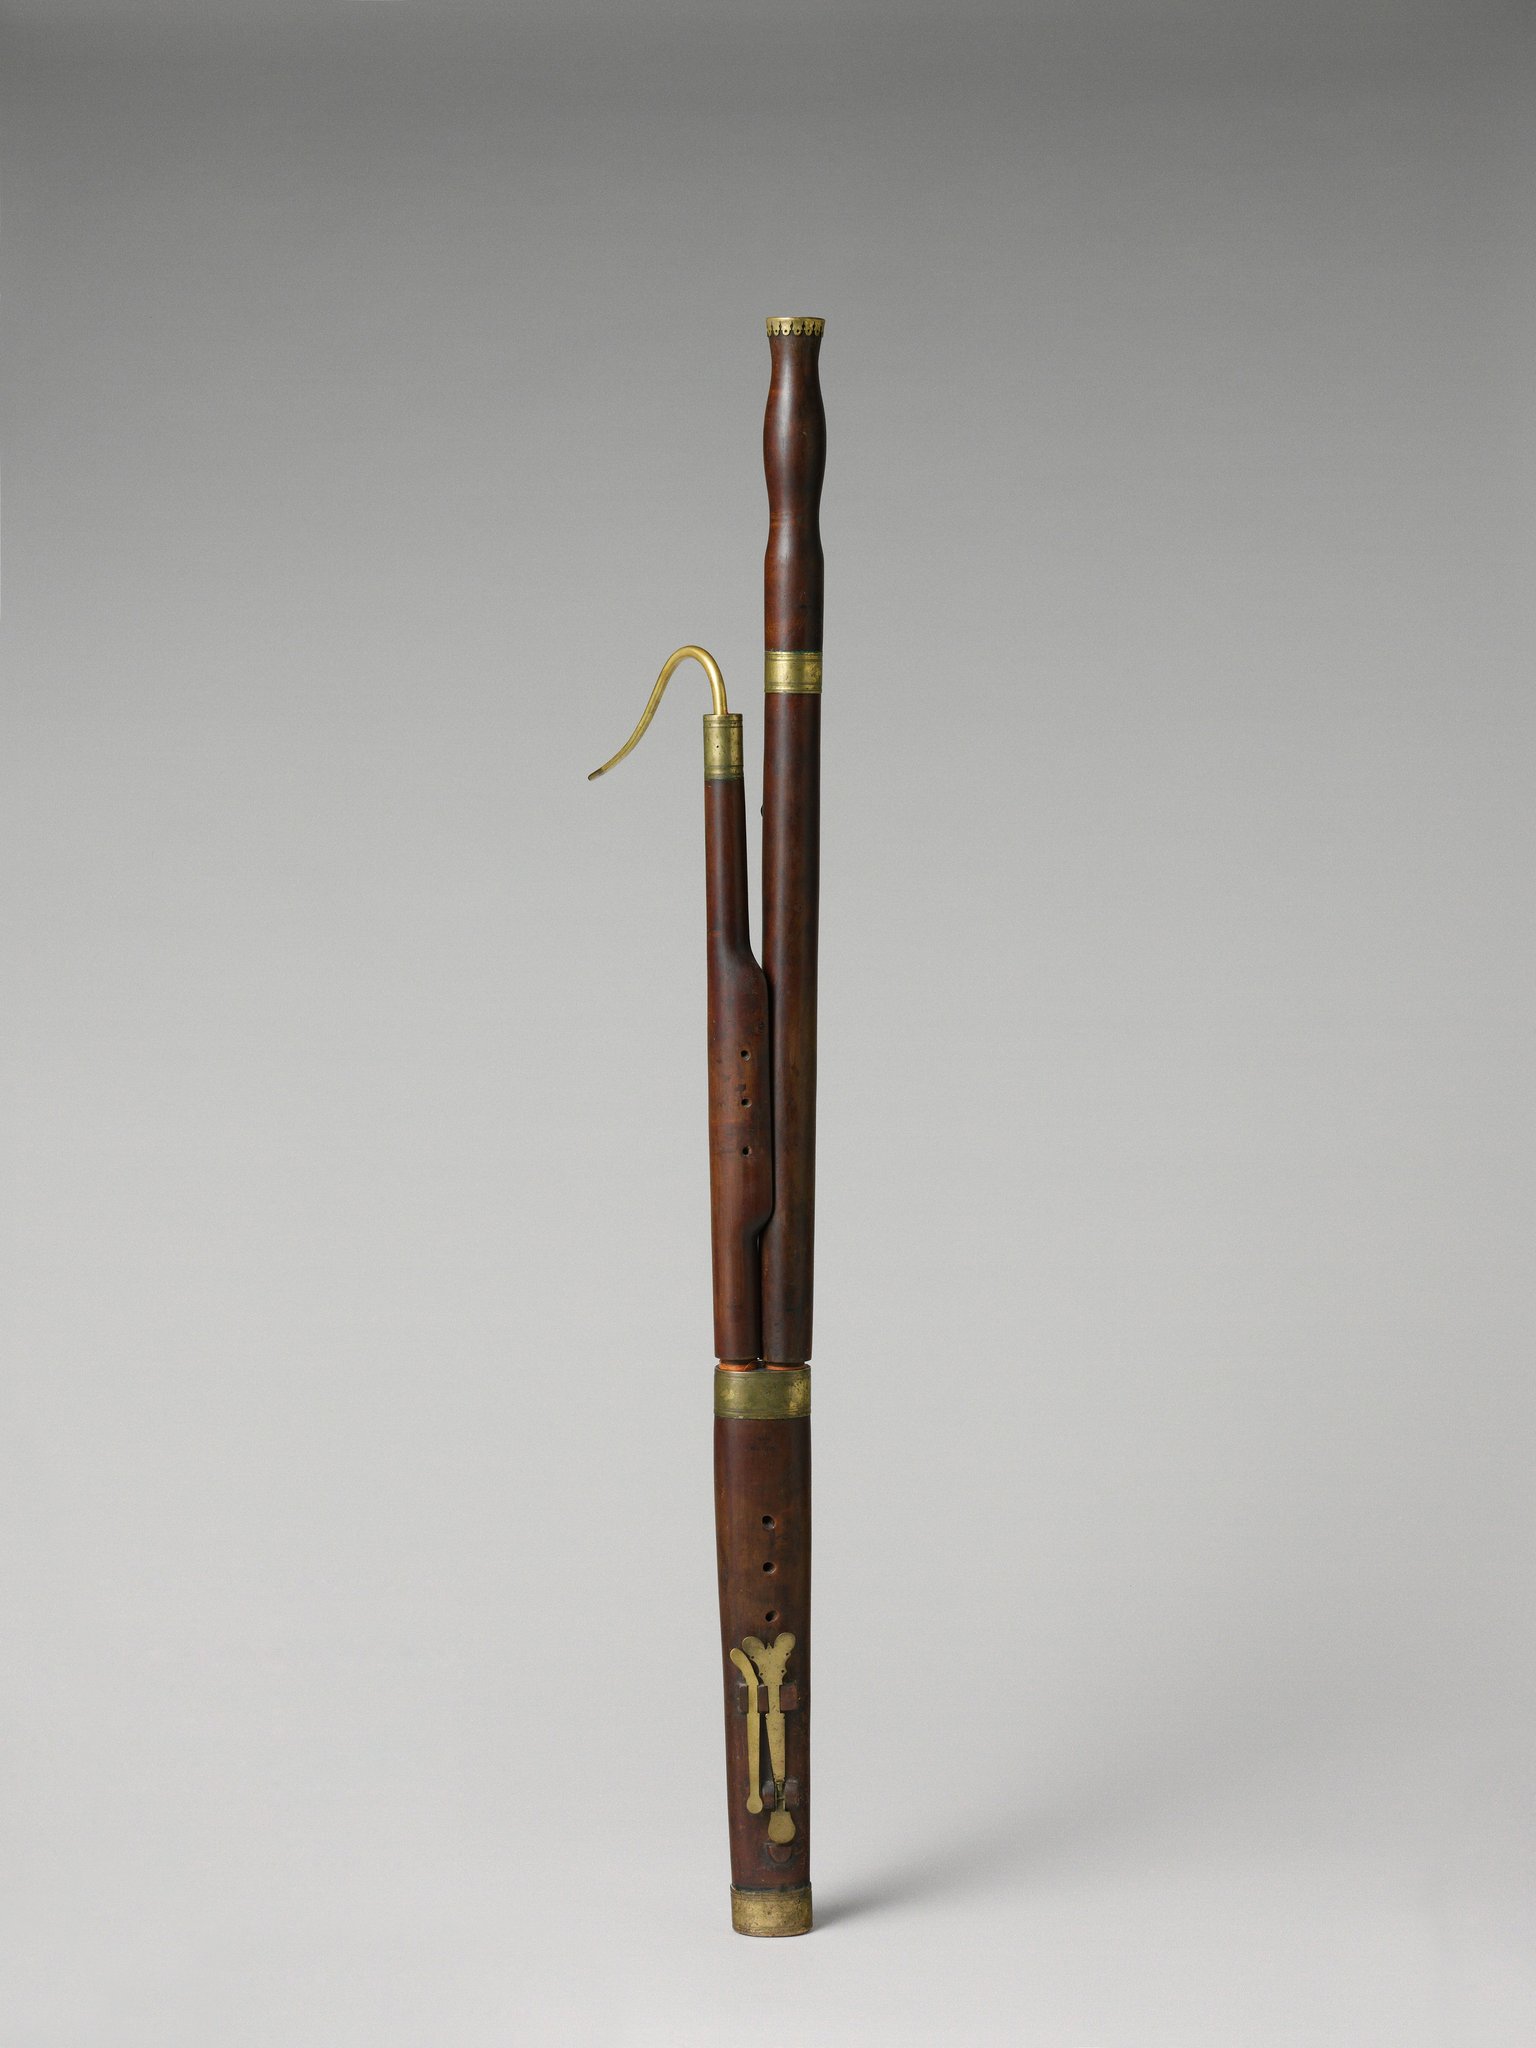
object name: bassoon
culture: german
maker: wolfgang thomae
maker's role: maker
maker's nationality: german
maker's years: 1771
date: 1750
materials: brass, wood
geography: germany